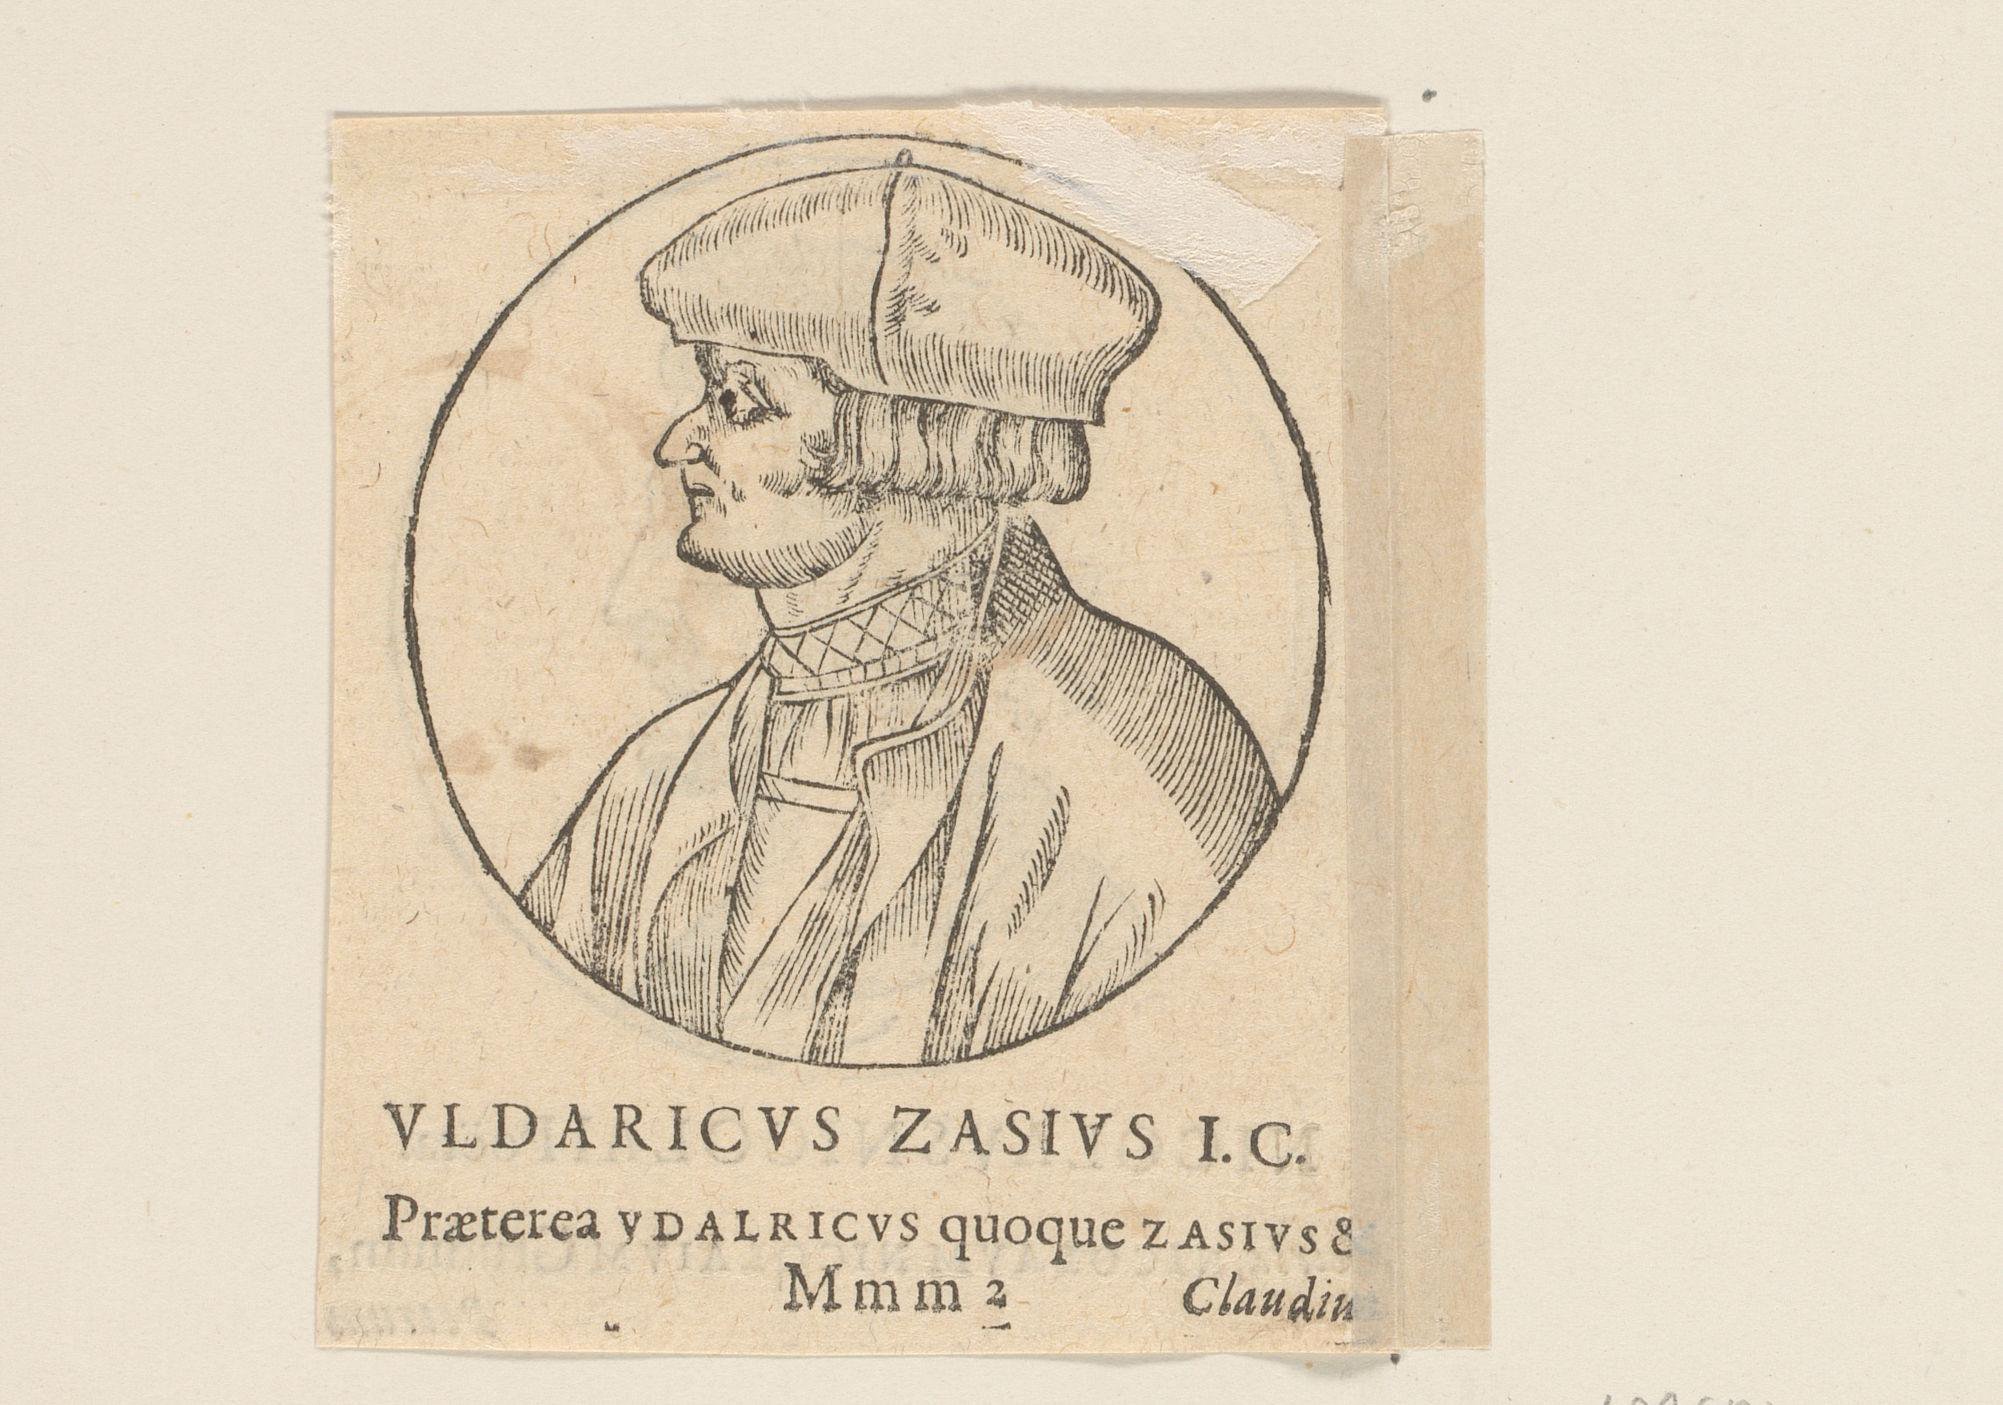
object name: print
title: Portret van Ulrich Zasius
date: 1600-1700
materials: paper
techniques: letterpress printing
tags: historical persons, writer, poet, author